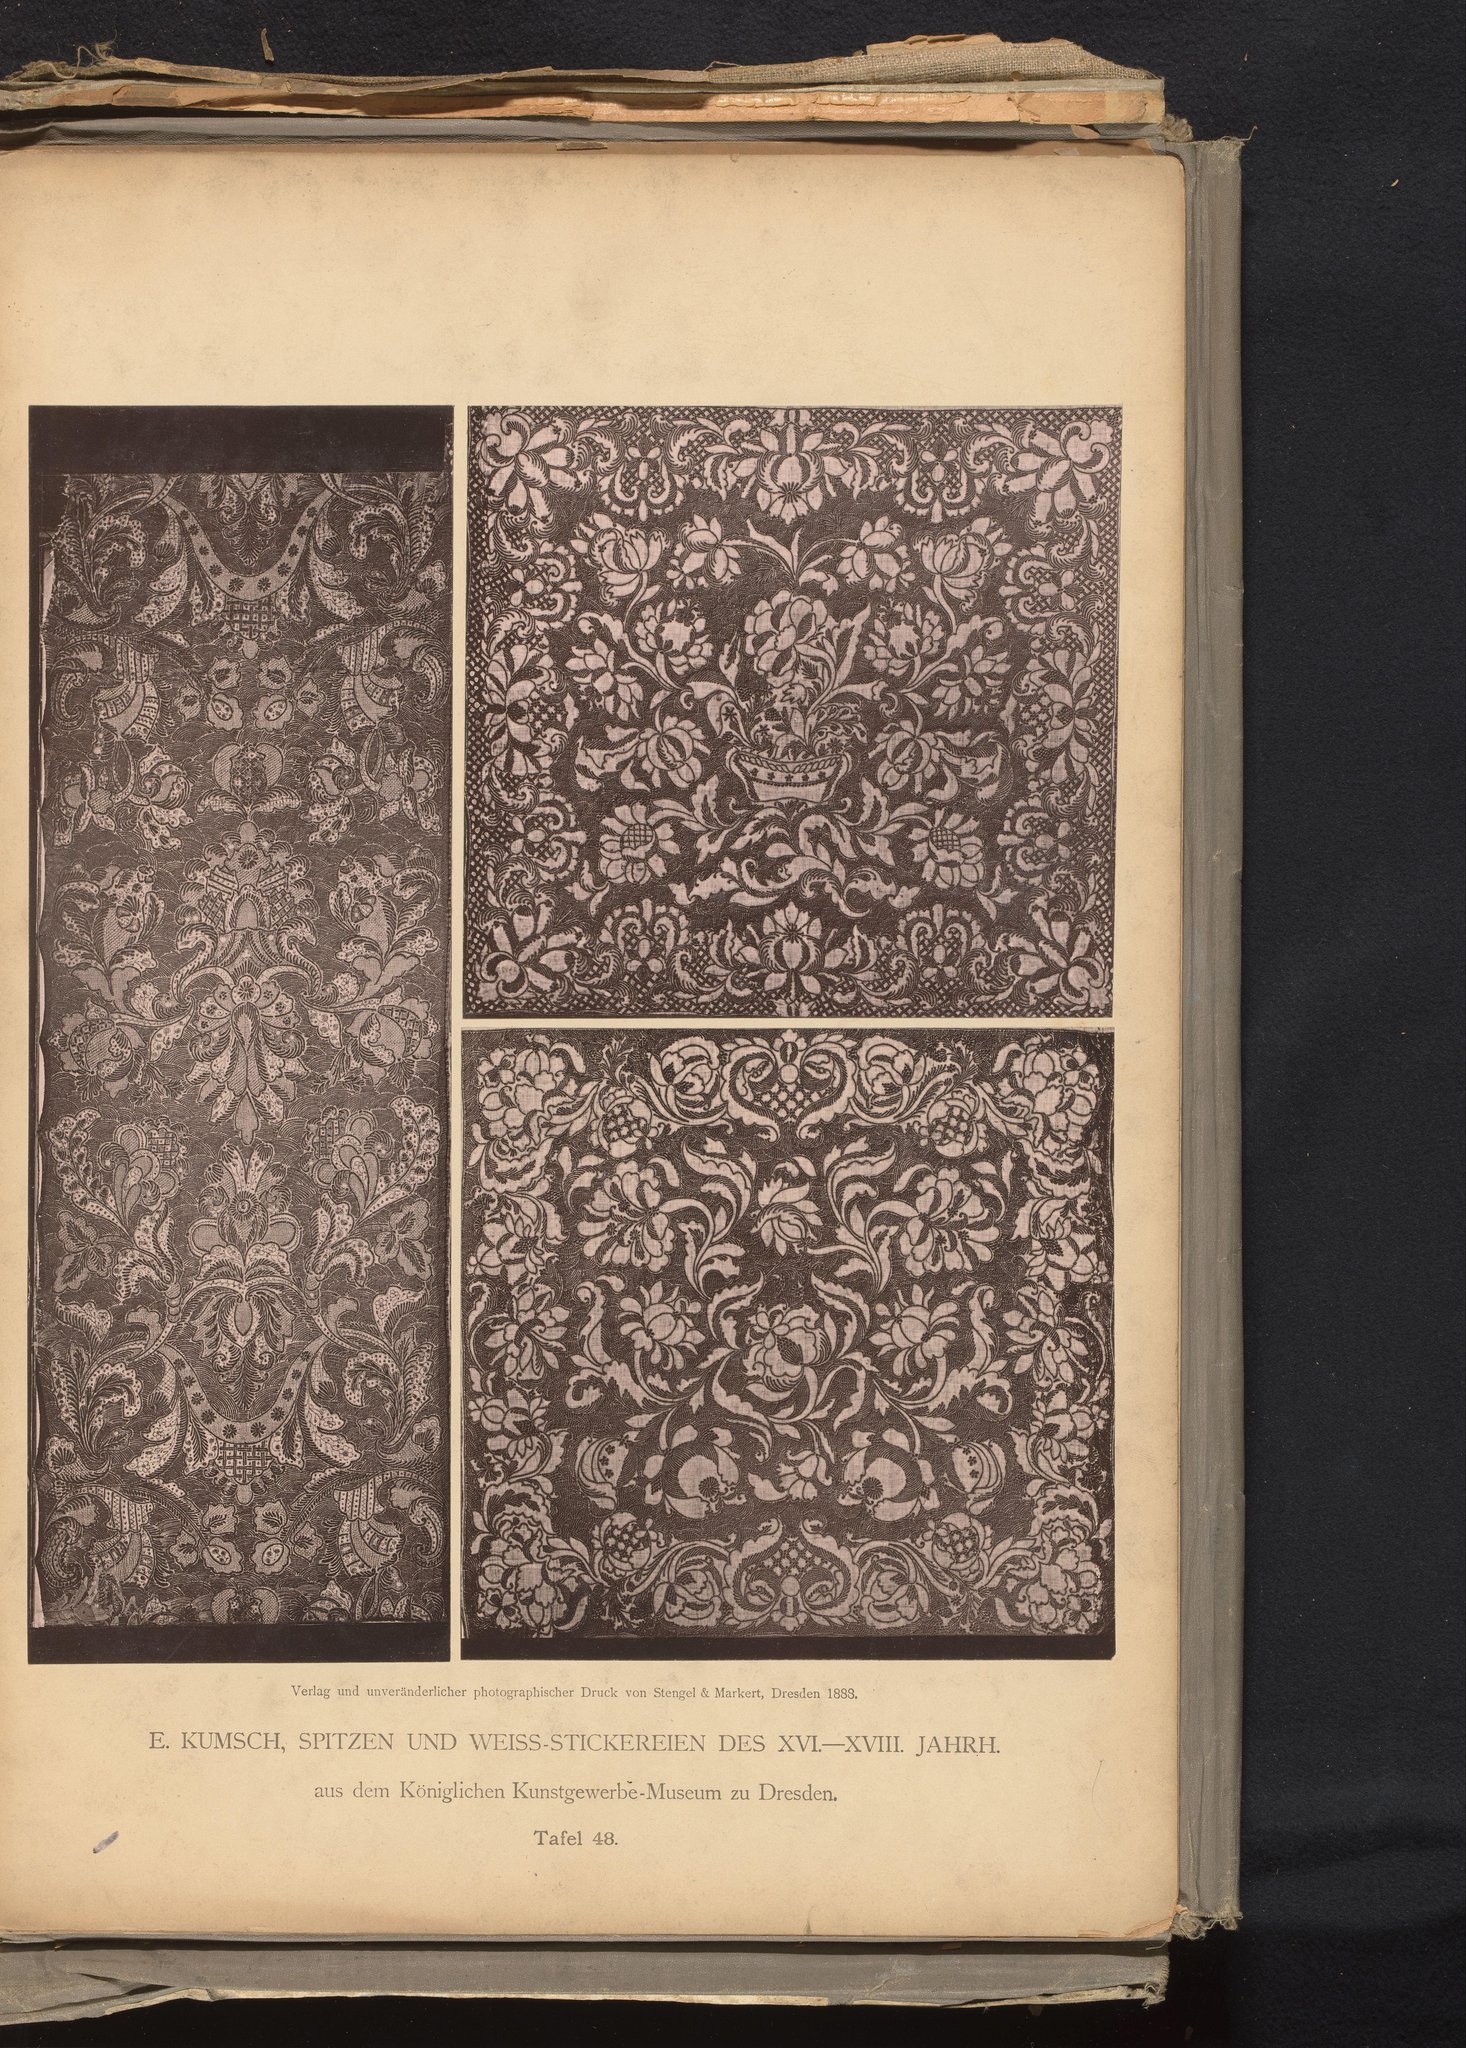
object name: photomechanical print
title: Drie stukken 18de-eeuws Duits borduurwerk uit de collectie van het Kunstgewerbemuseum in Dresden, Duitsland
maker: Anonymous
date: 1888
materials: paper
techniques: photograph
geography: dresden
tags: embroidery (ornamentation)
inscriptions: number: ‘Tafel 48.’, inscription: ‘E. KUMSCH, SPITZEN UND WEISS-STICKEREIEN DES XVI.-XVIII. JAHRH./ aus dem Königlichen Kunstgewerbe-Museum zu Dresden’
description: Deze prent maakt deel uit van een omslag met 49 prenten en een lijst van afbeeldingen.